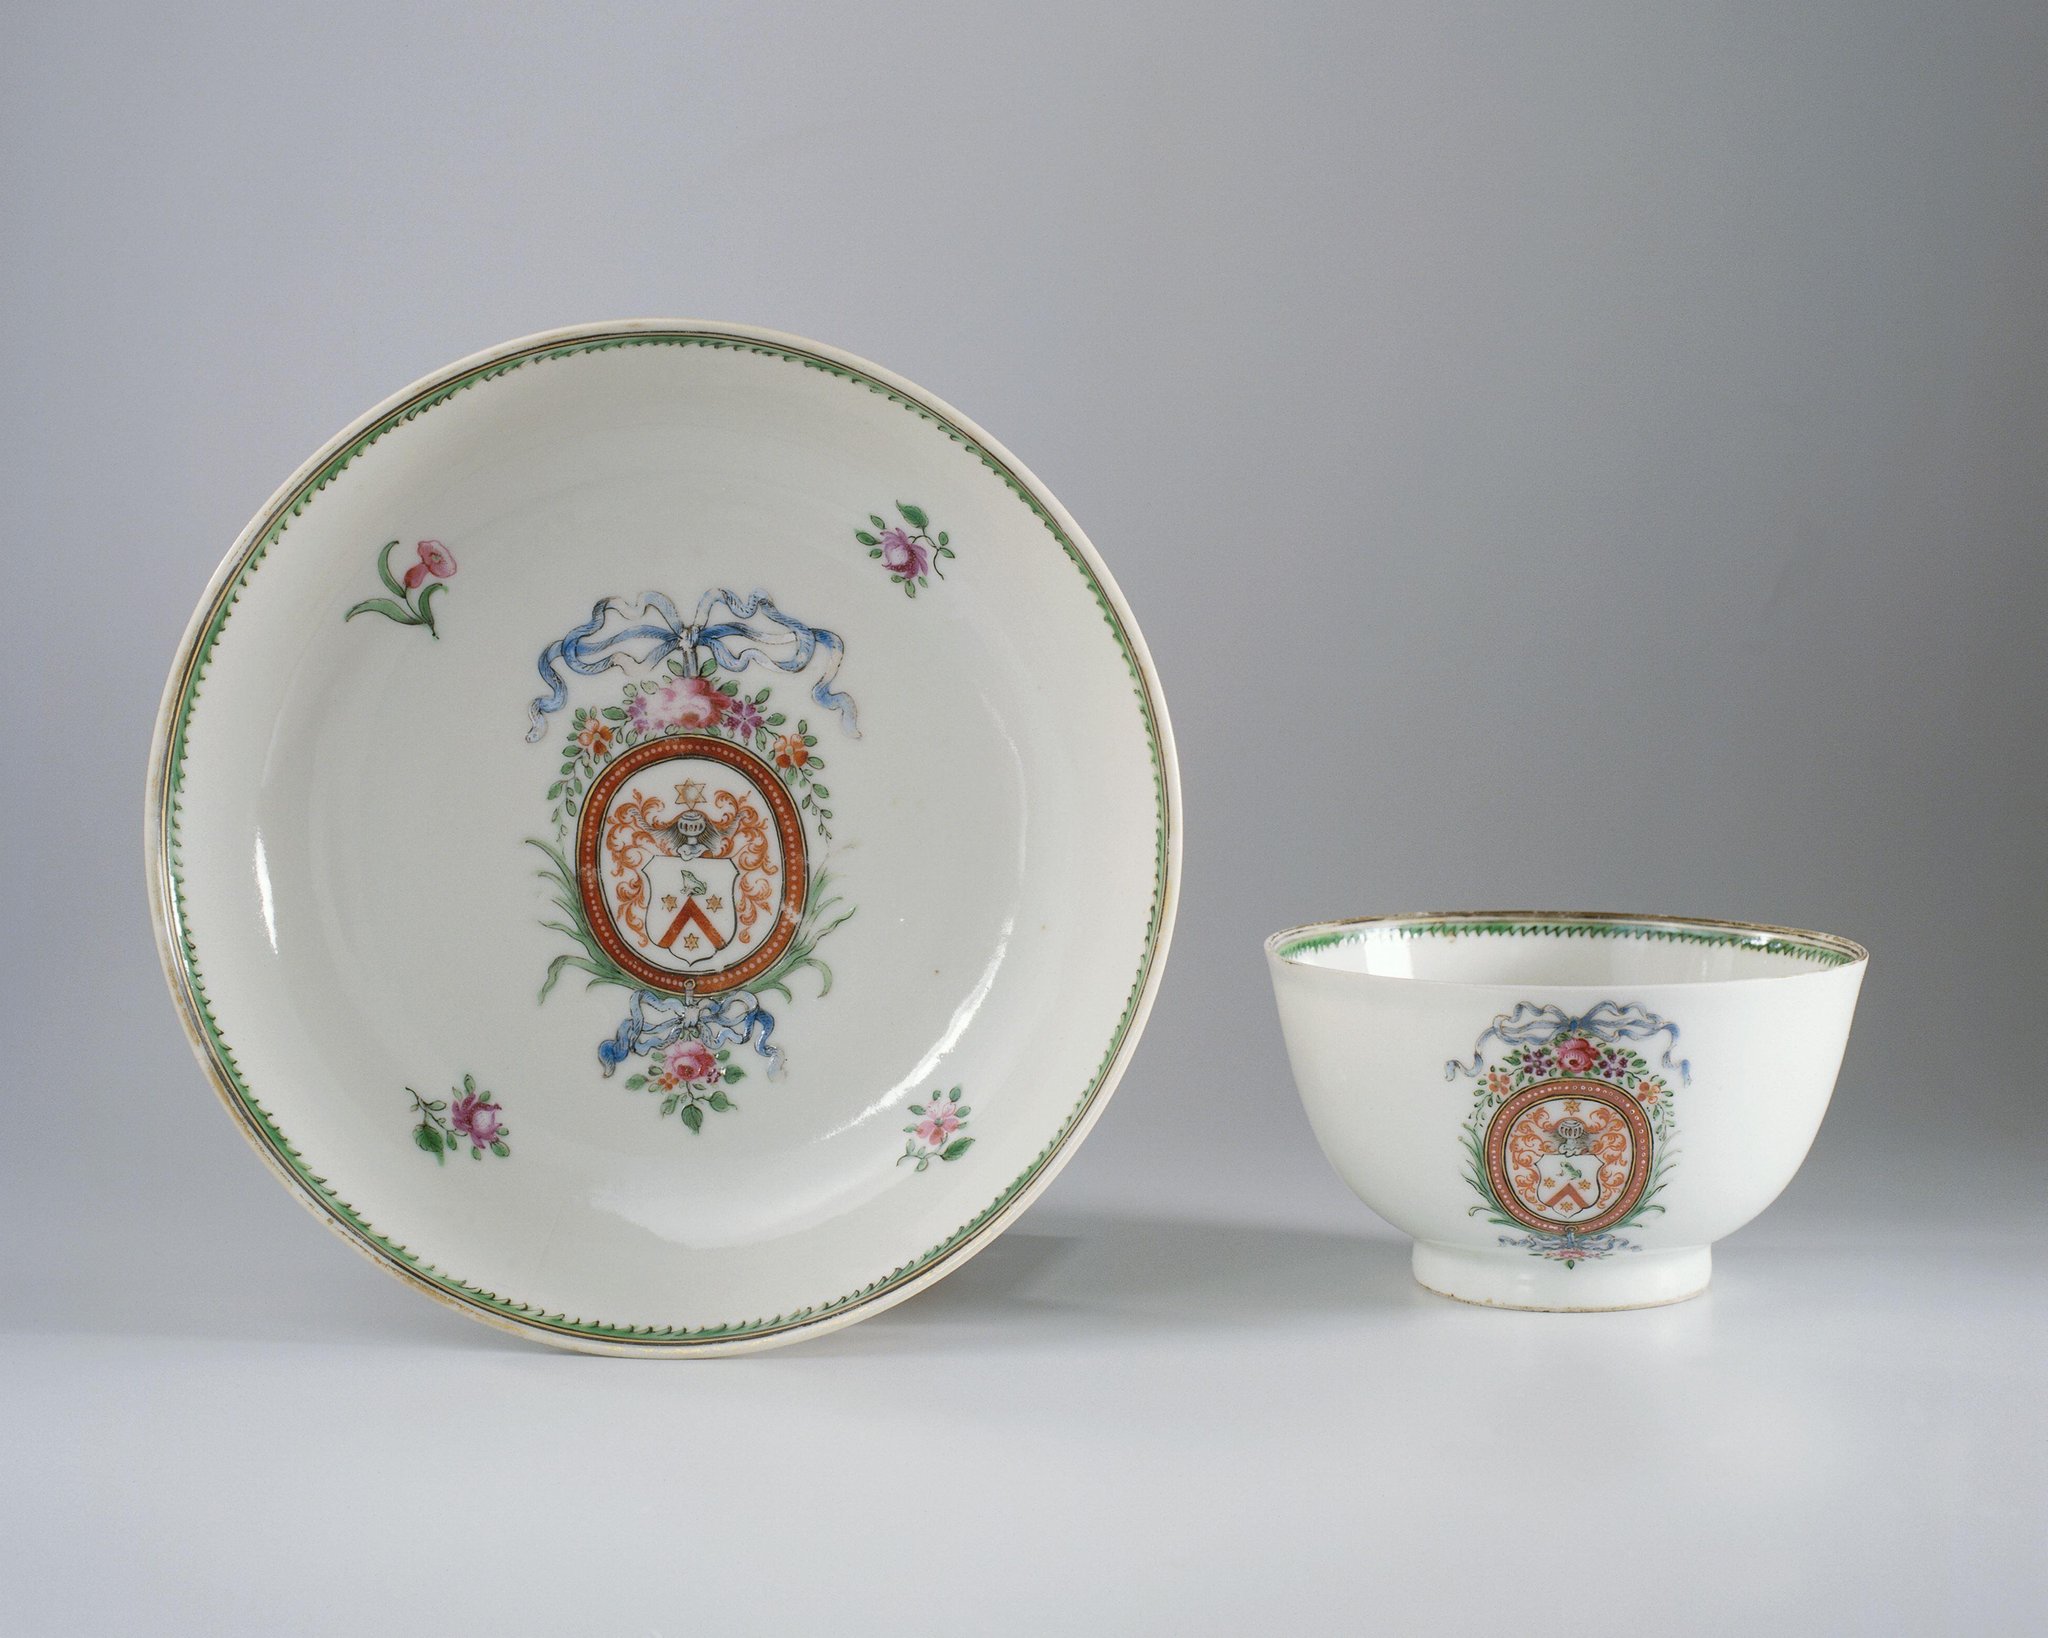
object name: platter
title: Saucer with the arms of the Kikkert family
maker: Anonymous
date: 1777-1778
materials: glaze, gold, paint, porcelain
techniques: firing, gilding, turning, vitrification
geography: china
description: In het centrum van de schotel en op de buitenzijde van de kop in een medaillon het wapen van de familie Kikkert. Het wapen heeft een rode keper met boven een kikker en twee sterren en onder een ster. Het helmteken is een ster en het dekkleed bestaat uit bladranken in ijzerrood. Het medaillon is versierd met strooibloemen, blauwe linten en twee groene palmtakken. Hieromheen zijn vier bloemtakken afgebeeld. Op de rand in de binnenzijde van zowel de kop als de schotel is een band in groen en goud.